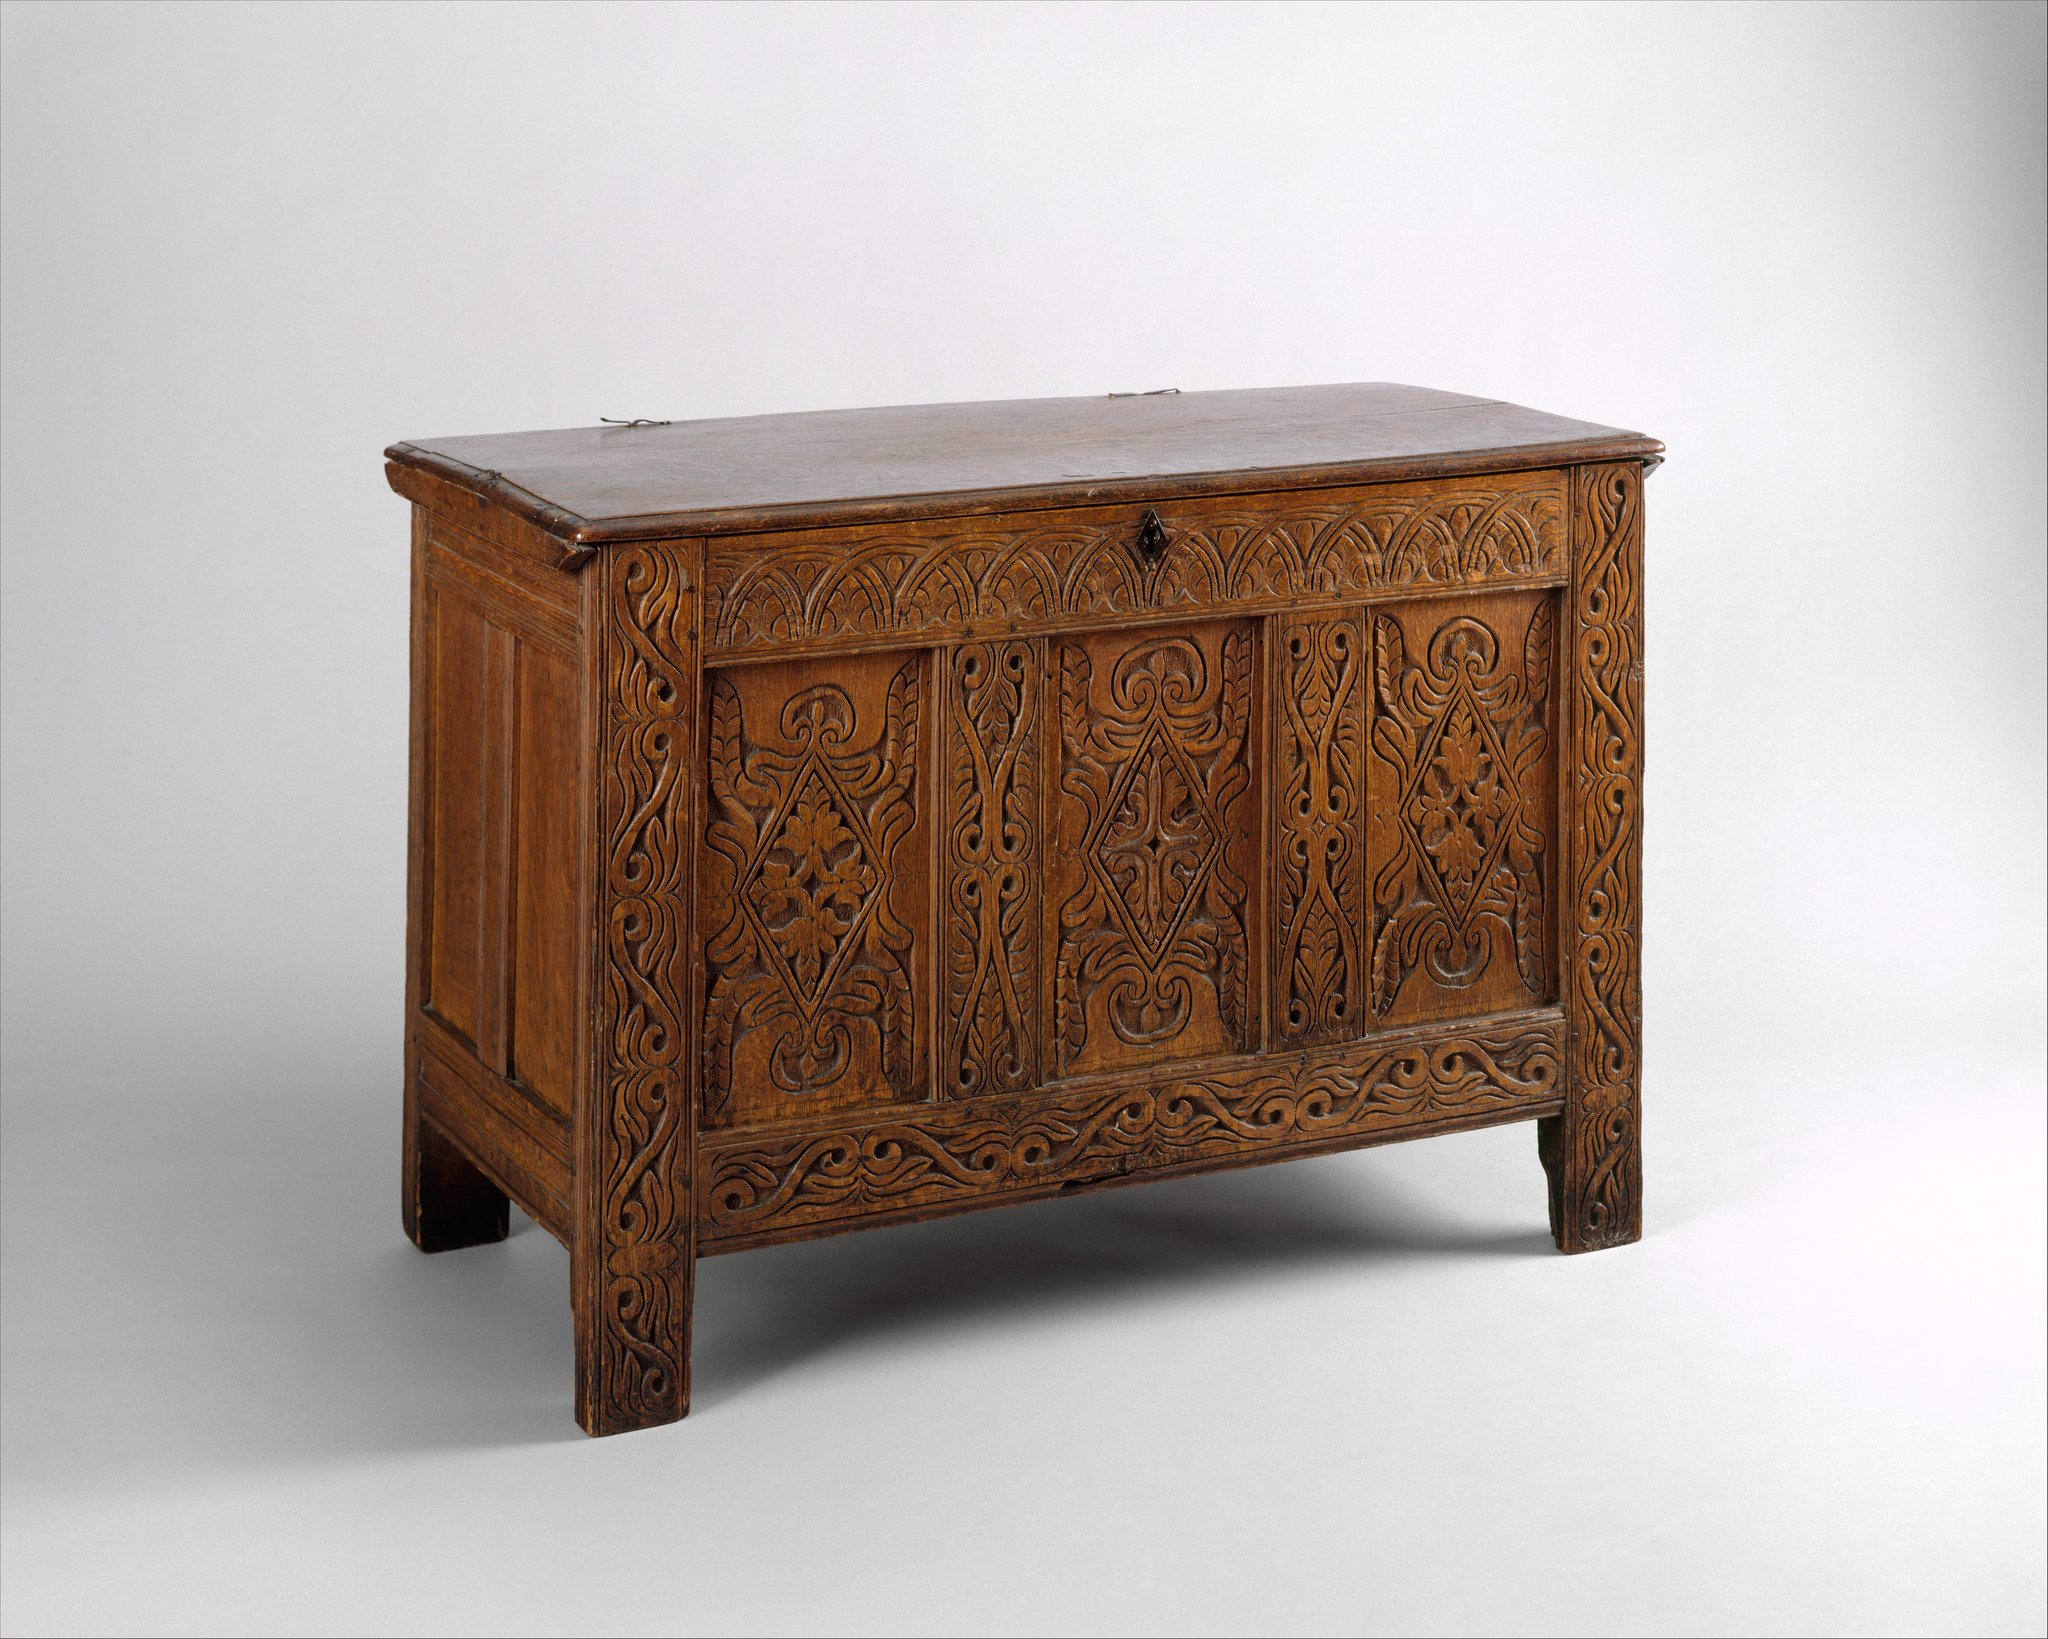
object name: chest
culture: american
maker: the searle-dennis shop tradition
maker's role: maker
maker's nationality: american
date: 1670-1690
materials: wood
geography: united states